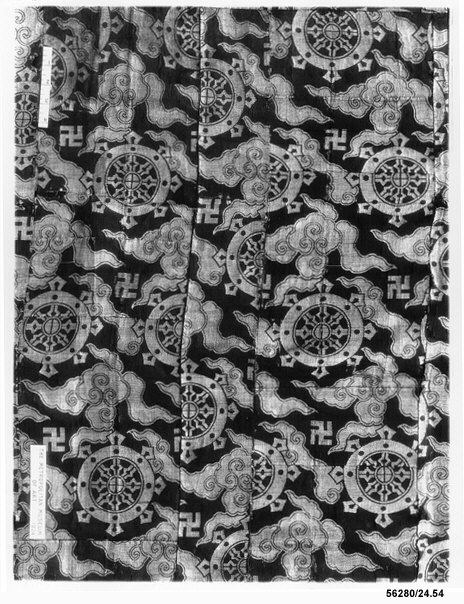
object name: robe, priest's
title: Priest's Robe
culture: japanese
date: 1601-1700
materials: metal thread, silk